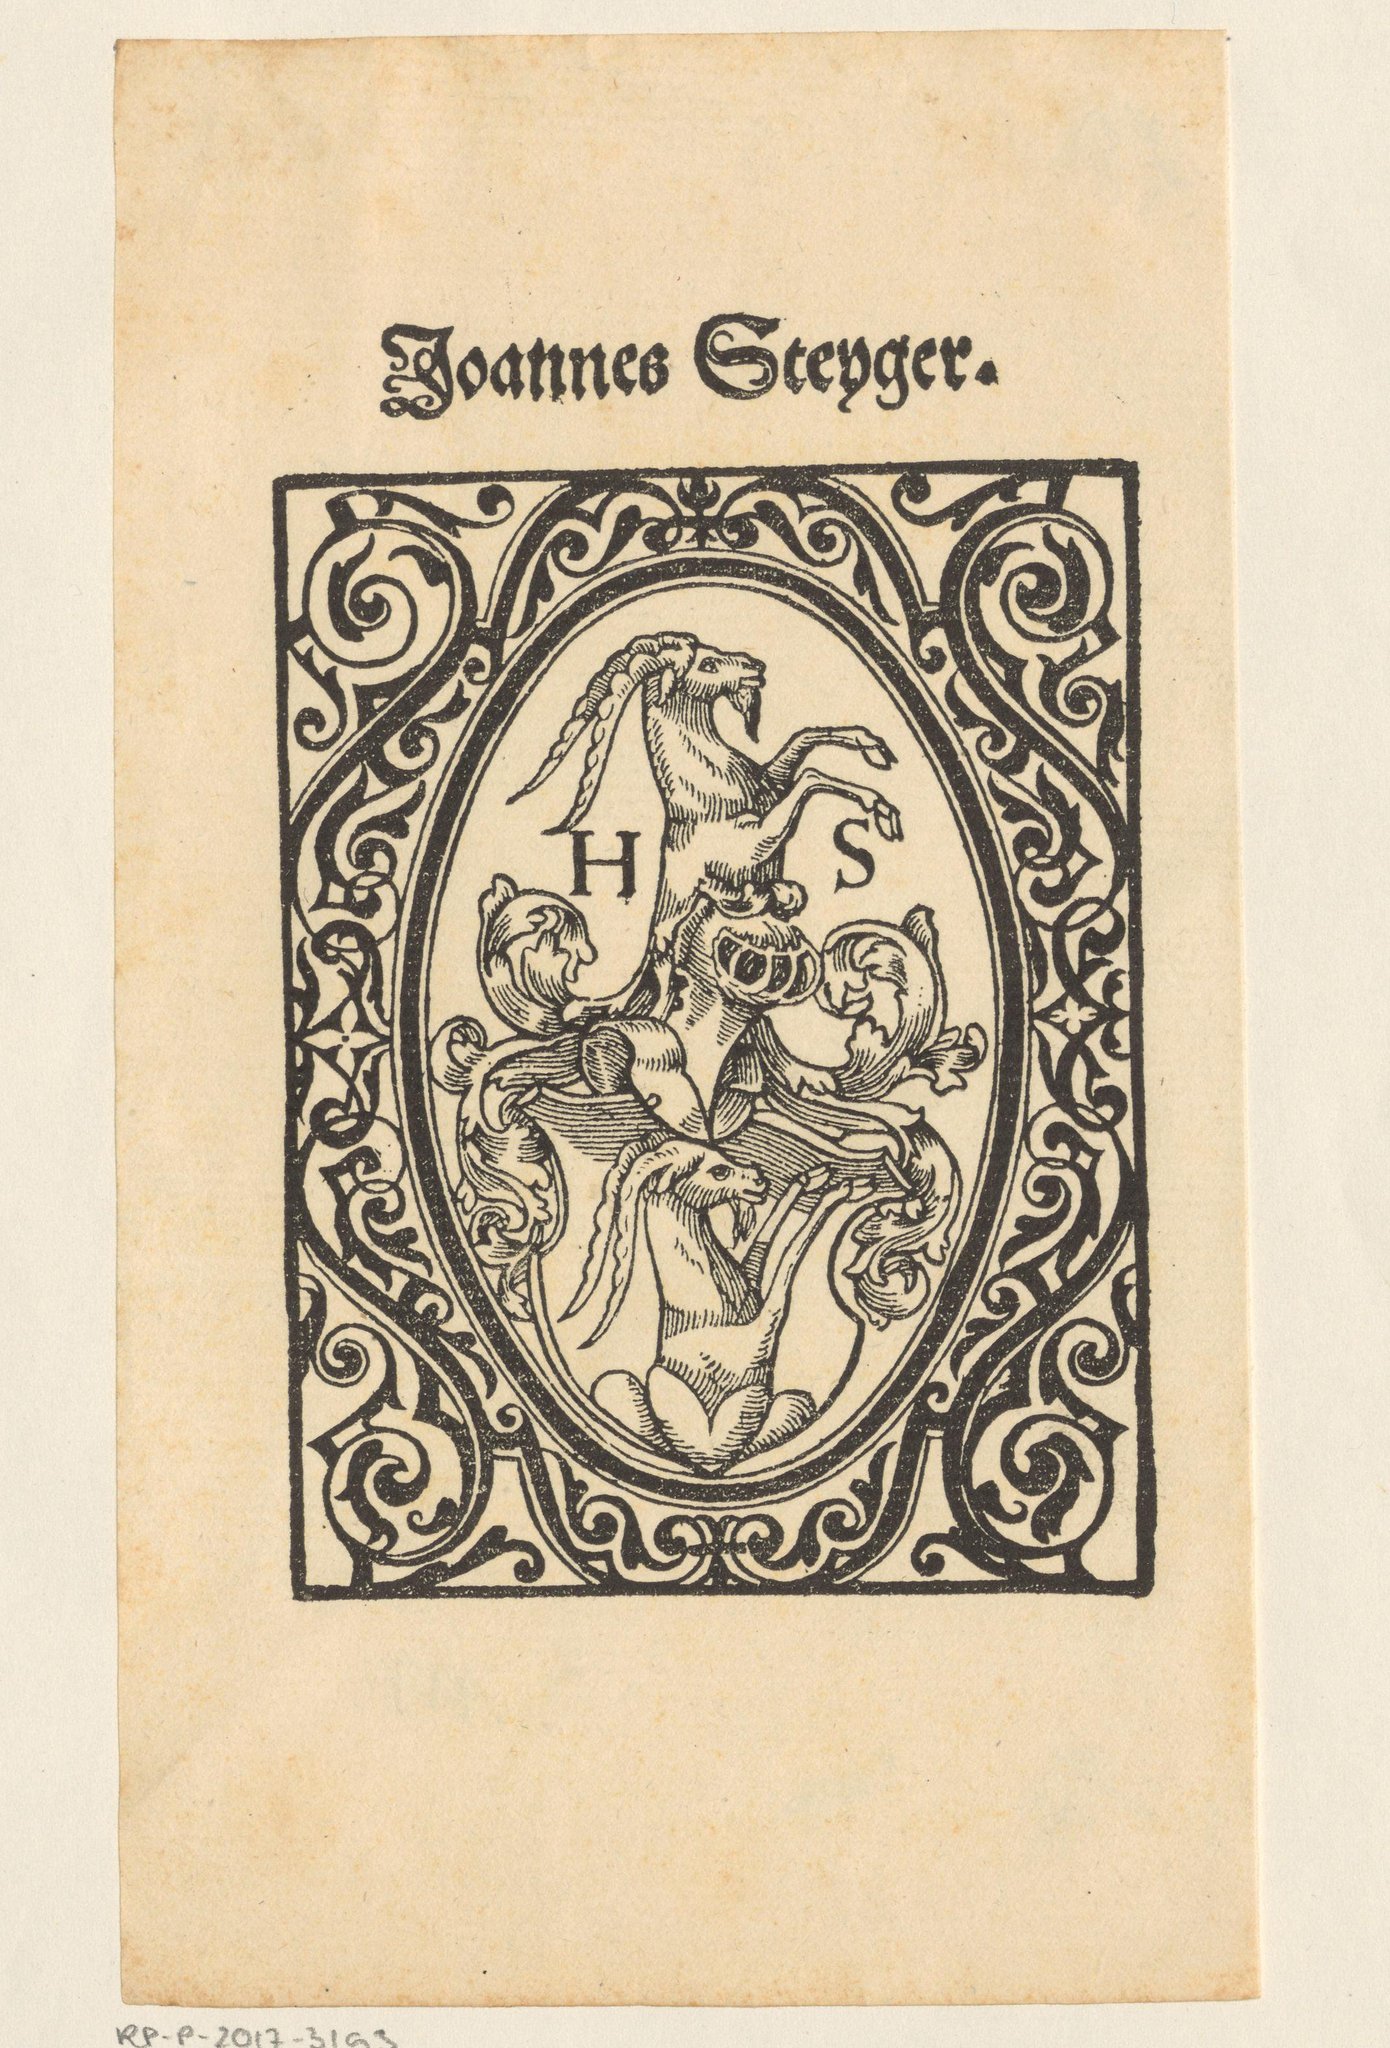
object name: bookplate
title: Ex libris van Joannes Steyger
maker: Anonymous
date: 1850-1950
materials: paper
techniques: printing block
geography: switzerland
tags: ram, armorial bearing, heraldry